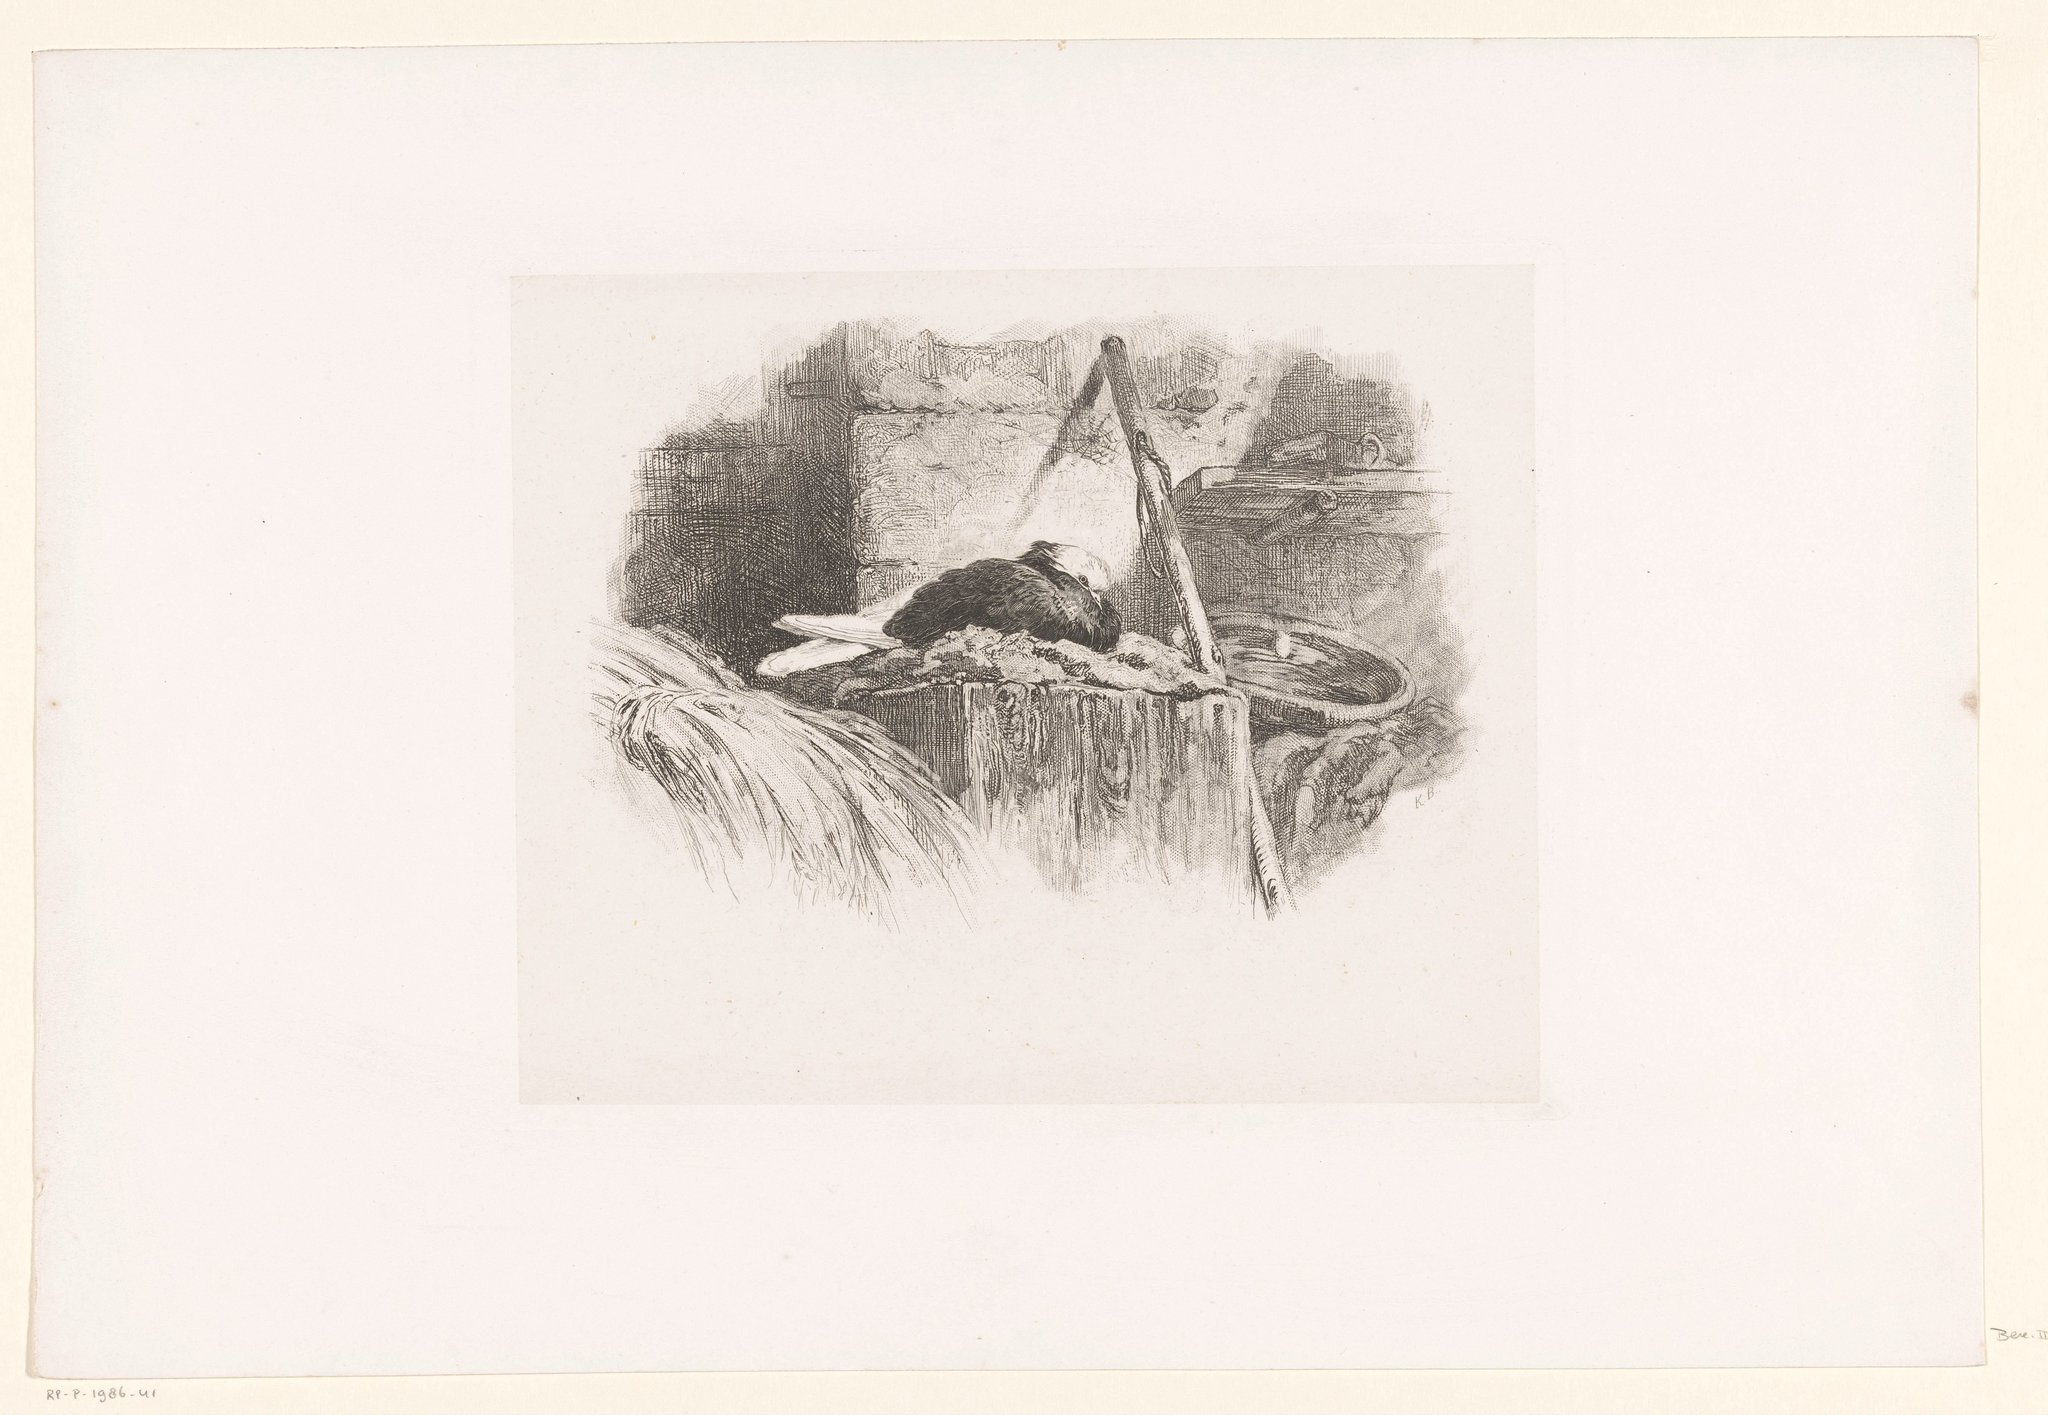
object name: print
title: Landschappen met dieren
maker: karl bodmer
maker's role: draughtsman, painter, print maker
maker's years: 1809-1893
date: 1847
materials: paper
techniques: etching, roulette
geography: paris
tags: doves, pigeons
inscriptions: collector's mark: Lugt 2228, collector's mark: Lugt 2228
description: Elfde prent uit een serie bestaand uit twaalf landschappen met dieren. De prenten vormen waarschijnlijk een uitwerking van de tekeningen die Bodmer maakte tijdens een expeditie door Noord-Amerika (1832-1834), onder leiding van prins Maximilian zu Wied-Neuwied.